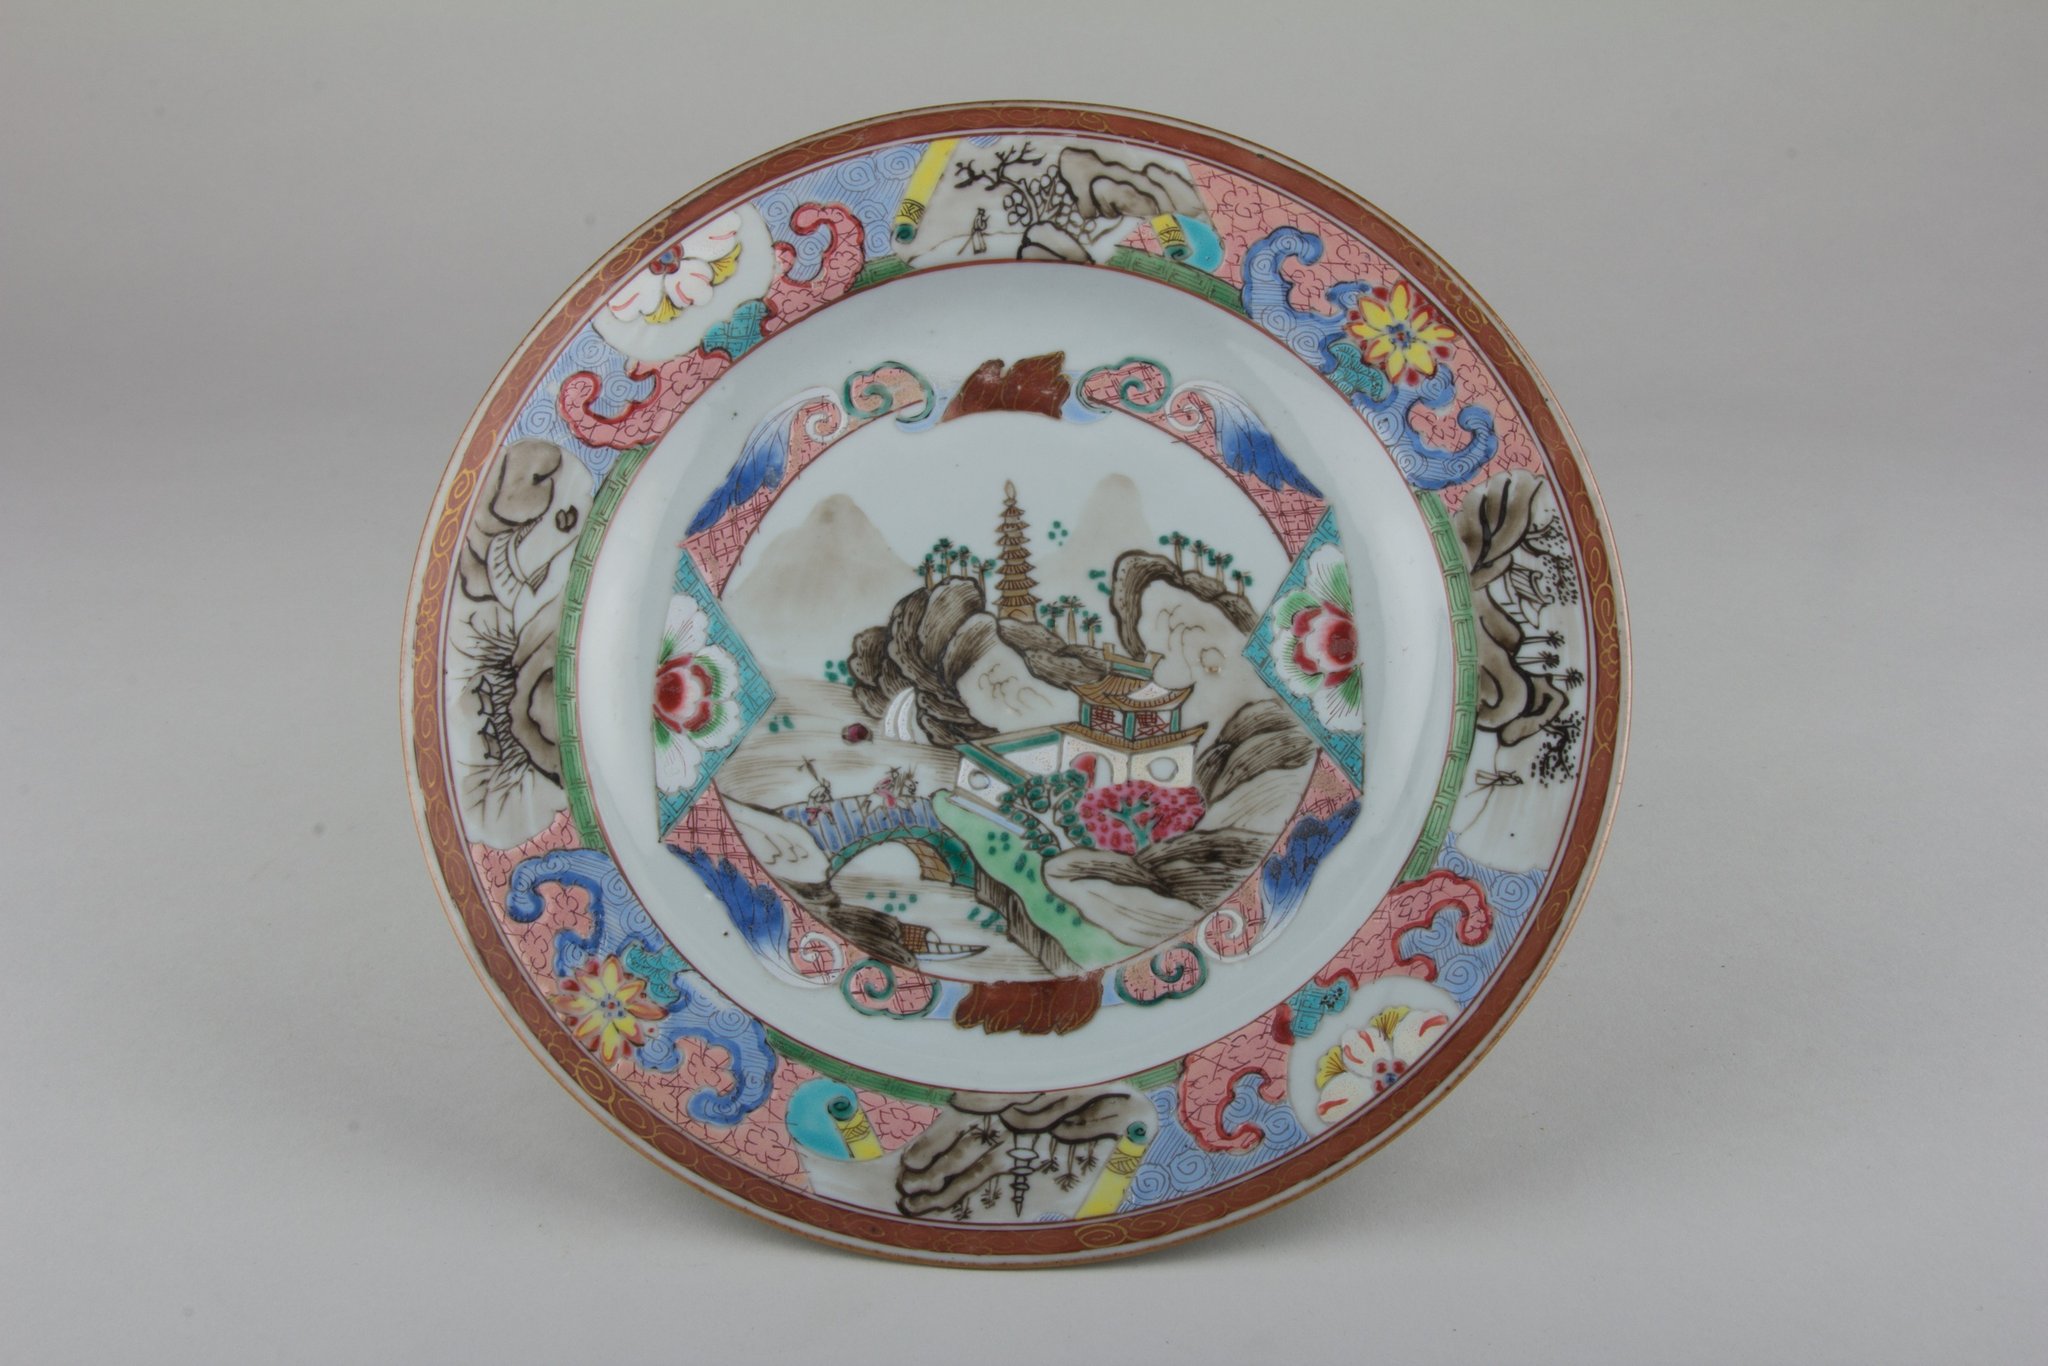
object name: plate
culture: chinese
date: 1736-1795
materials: enamel, porcelain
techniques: overglaze, painting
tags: flowers,mountains